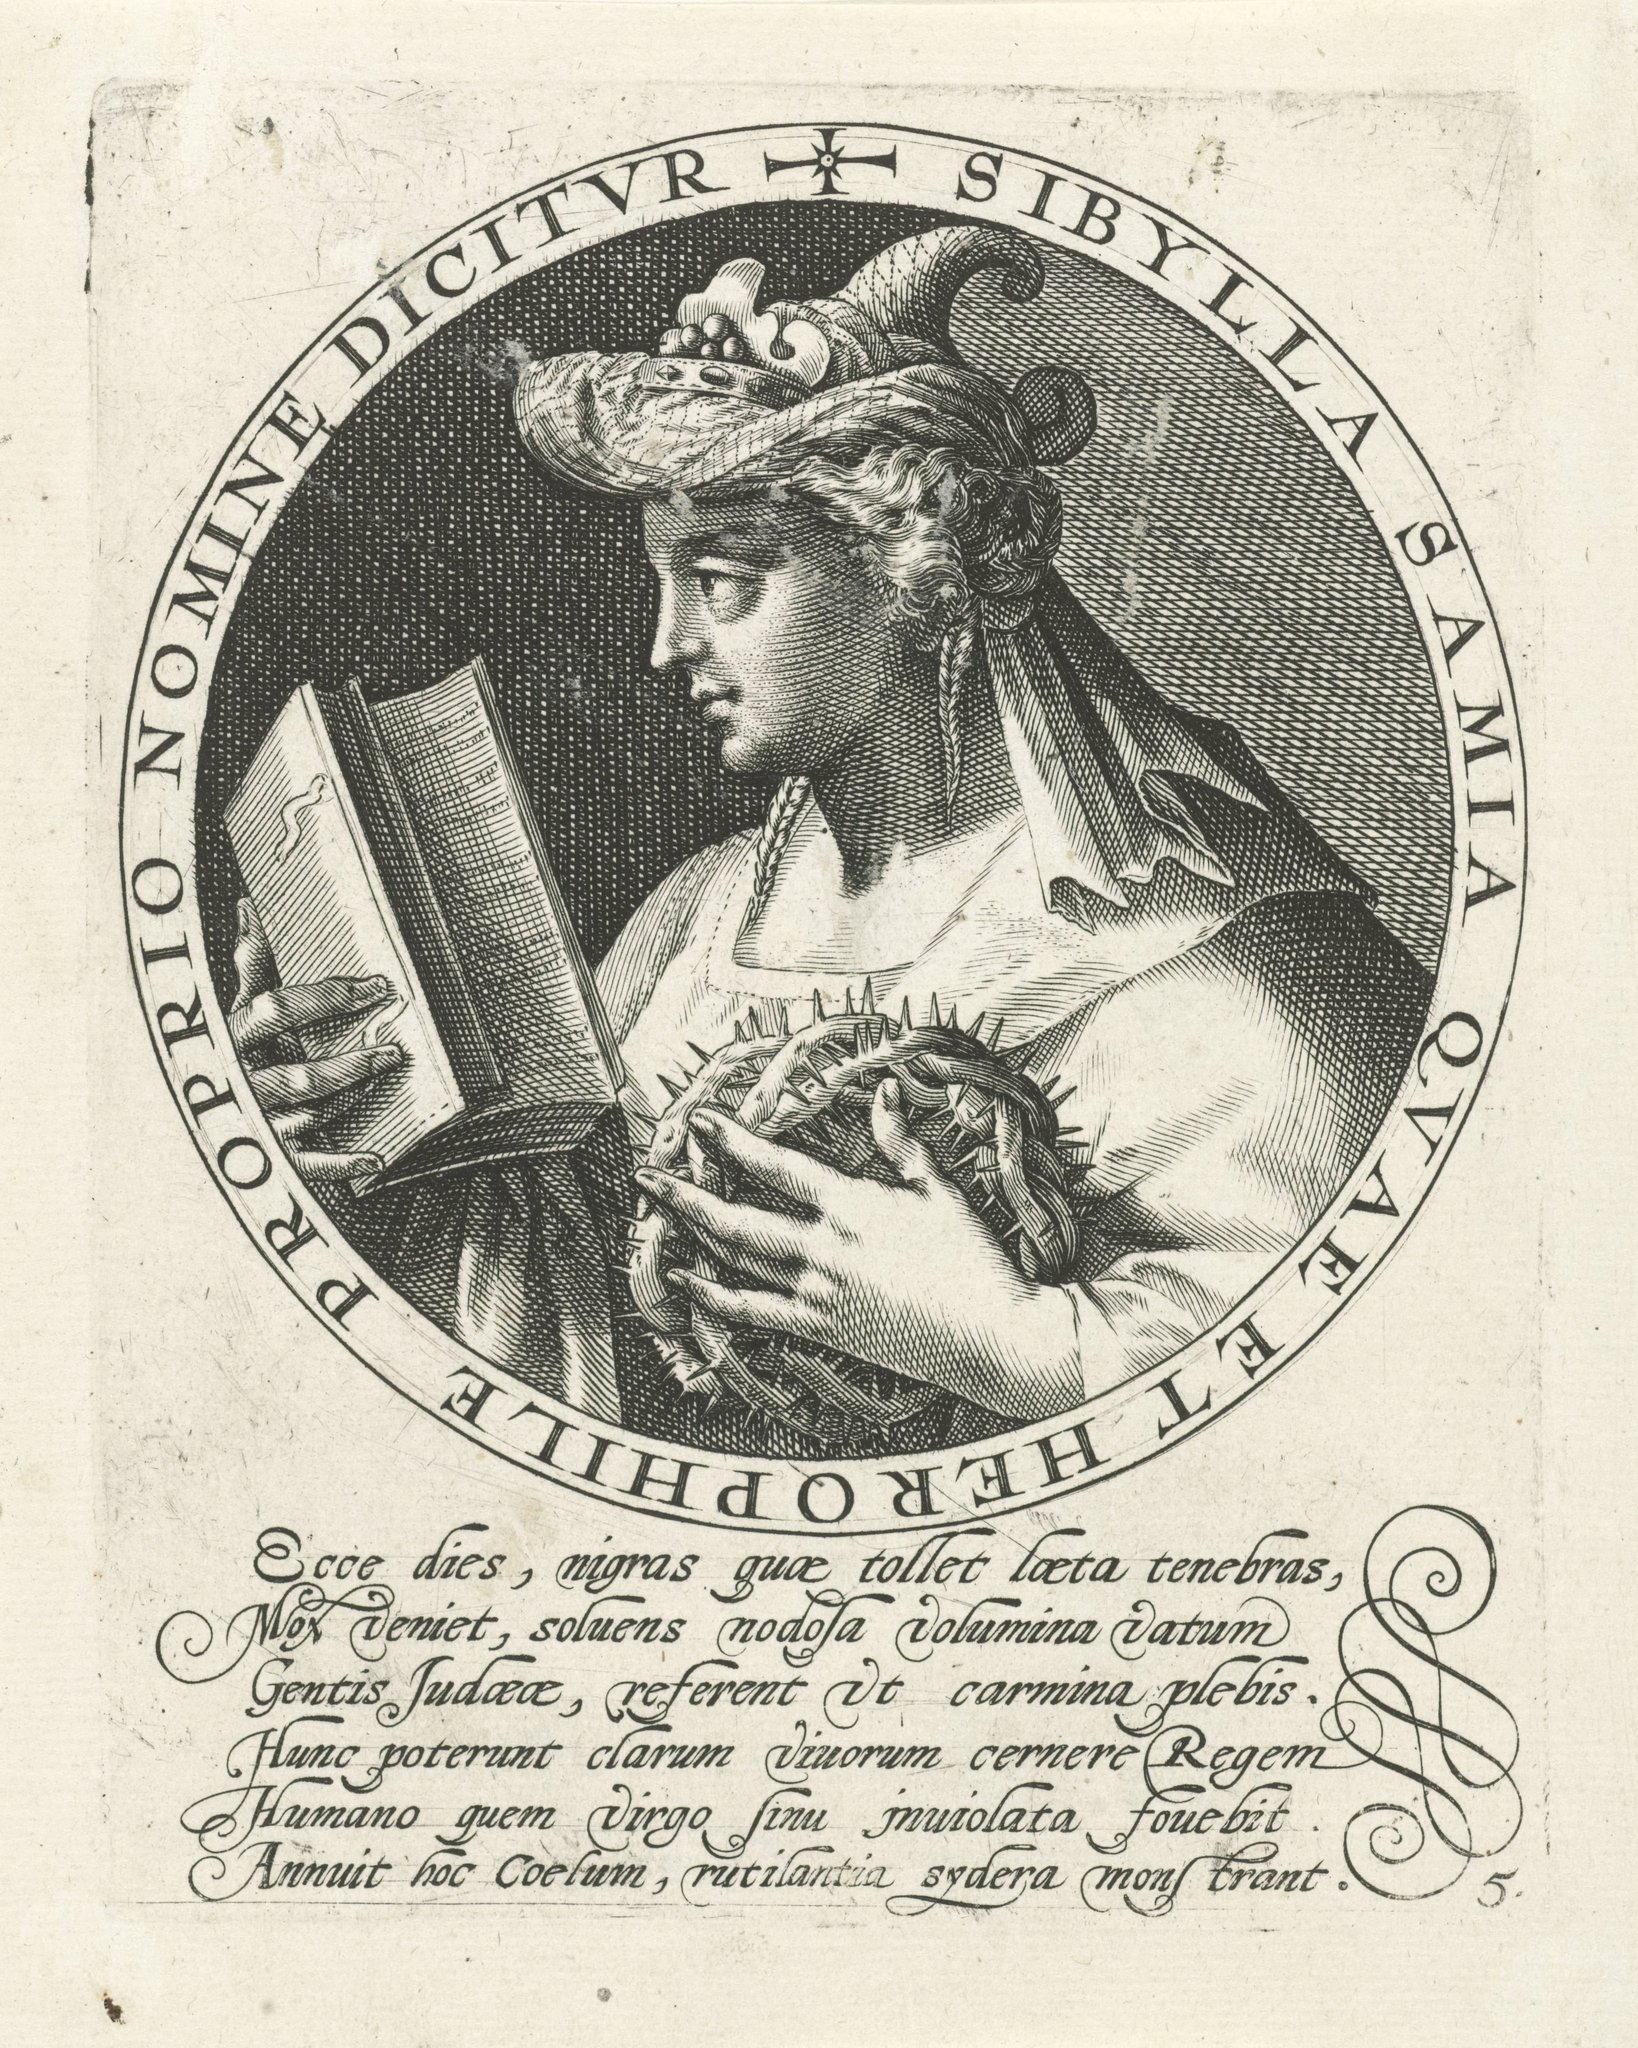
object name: print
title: De twaalf sibillen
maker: crispijn van de passe (i)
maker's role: draughtsman, print maker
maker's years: 1564-1637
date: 1601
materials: paper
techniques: engraving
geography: cologne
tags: samian sibyl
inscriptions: collector's mark: Lugt 2228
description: Buste van de Sibille van Samos. In haar linkerhand houdt ze een doornenkroon en in haar rechterhand een opengeslagen boek. De voorstelling is gevat in een medaillon met een randschrift in het Latijn. In de marge een zesregelig onderschrift in het Latijn. Prent uit een serie met de twaalf sibillen.